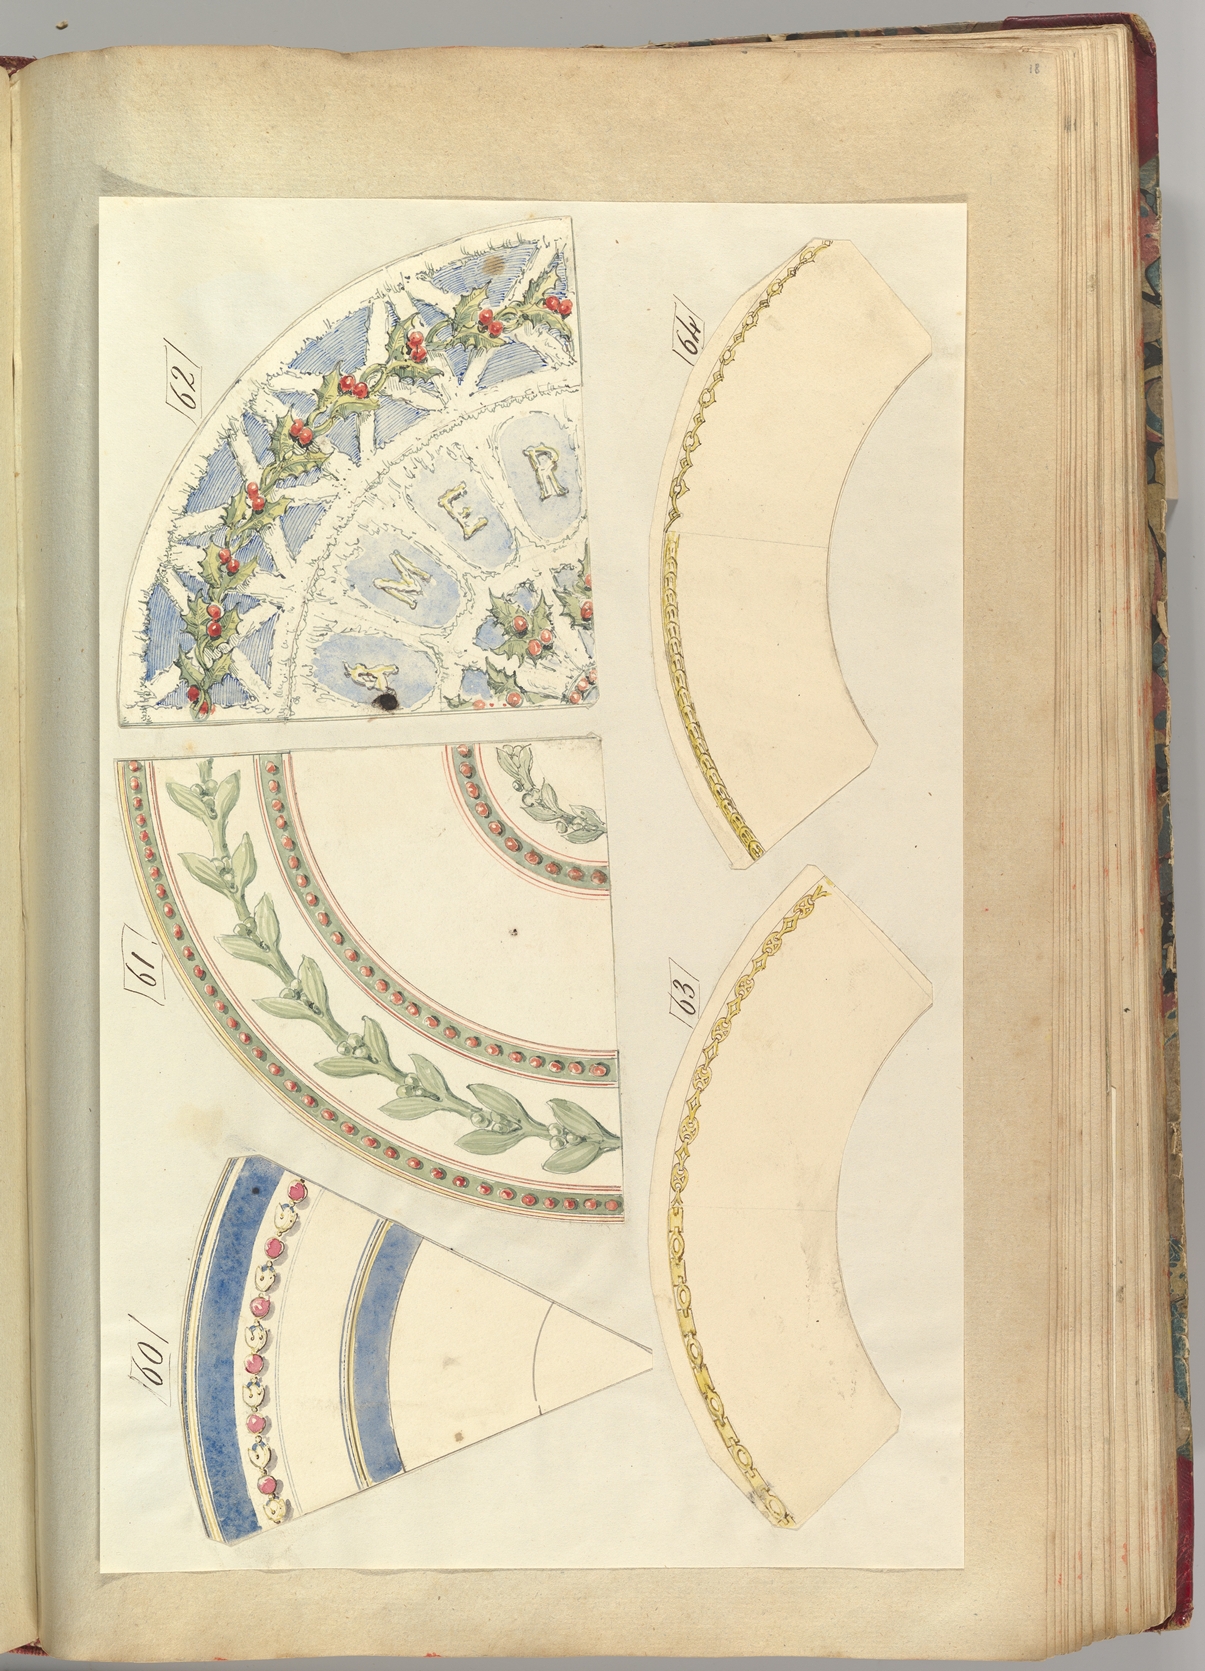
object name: drawing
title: Five Designs for Decorated Plates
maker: alfred henry forrester [alfred crowquill]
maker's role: artist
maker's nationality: british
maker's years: 1804-1872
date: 1845-1855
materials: ink, watercolor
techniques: pen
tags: dishes